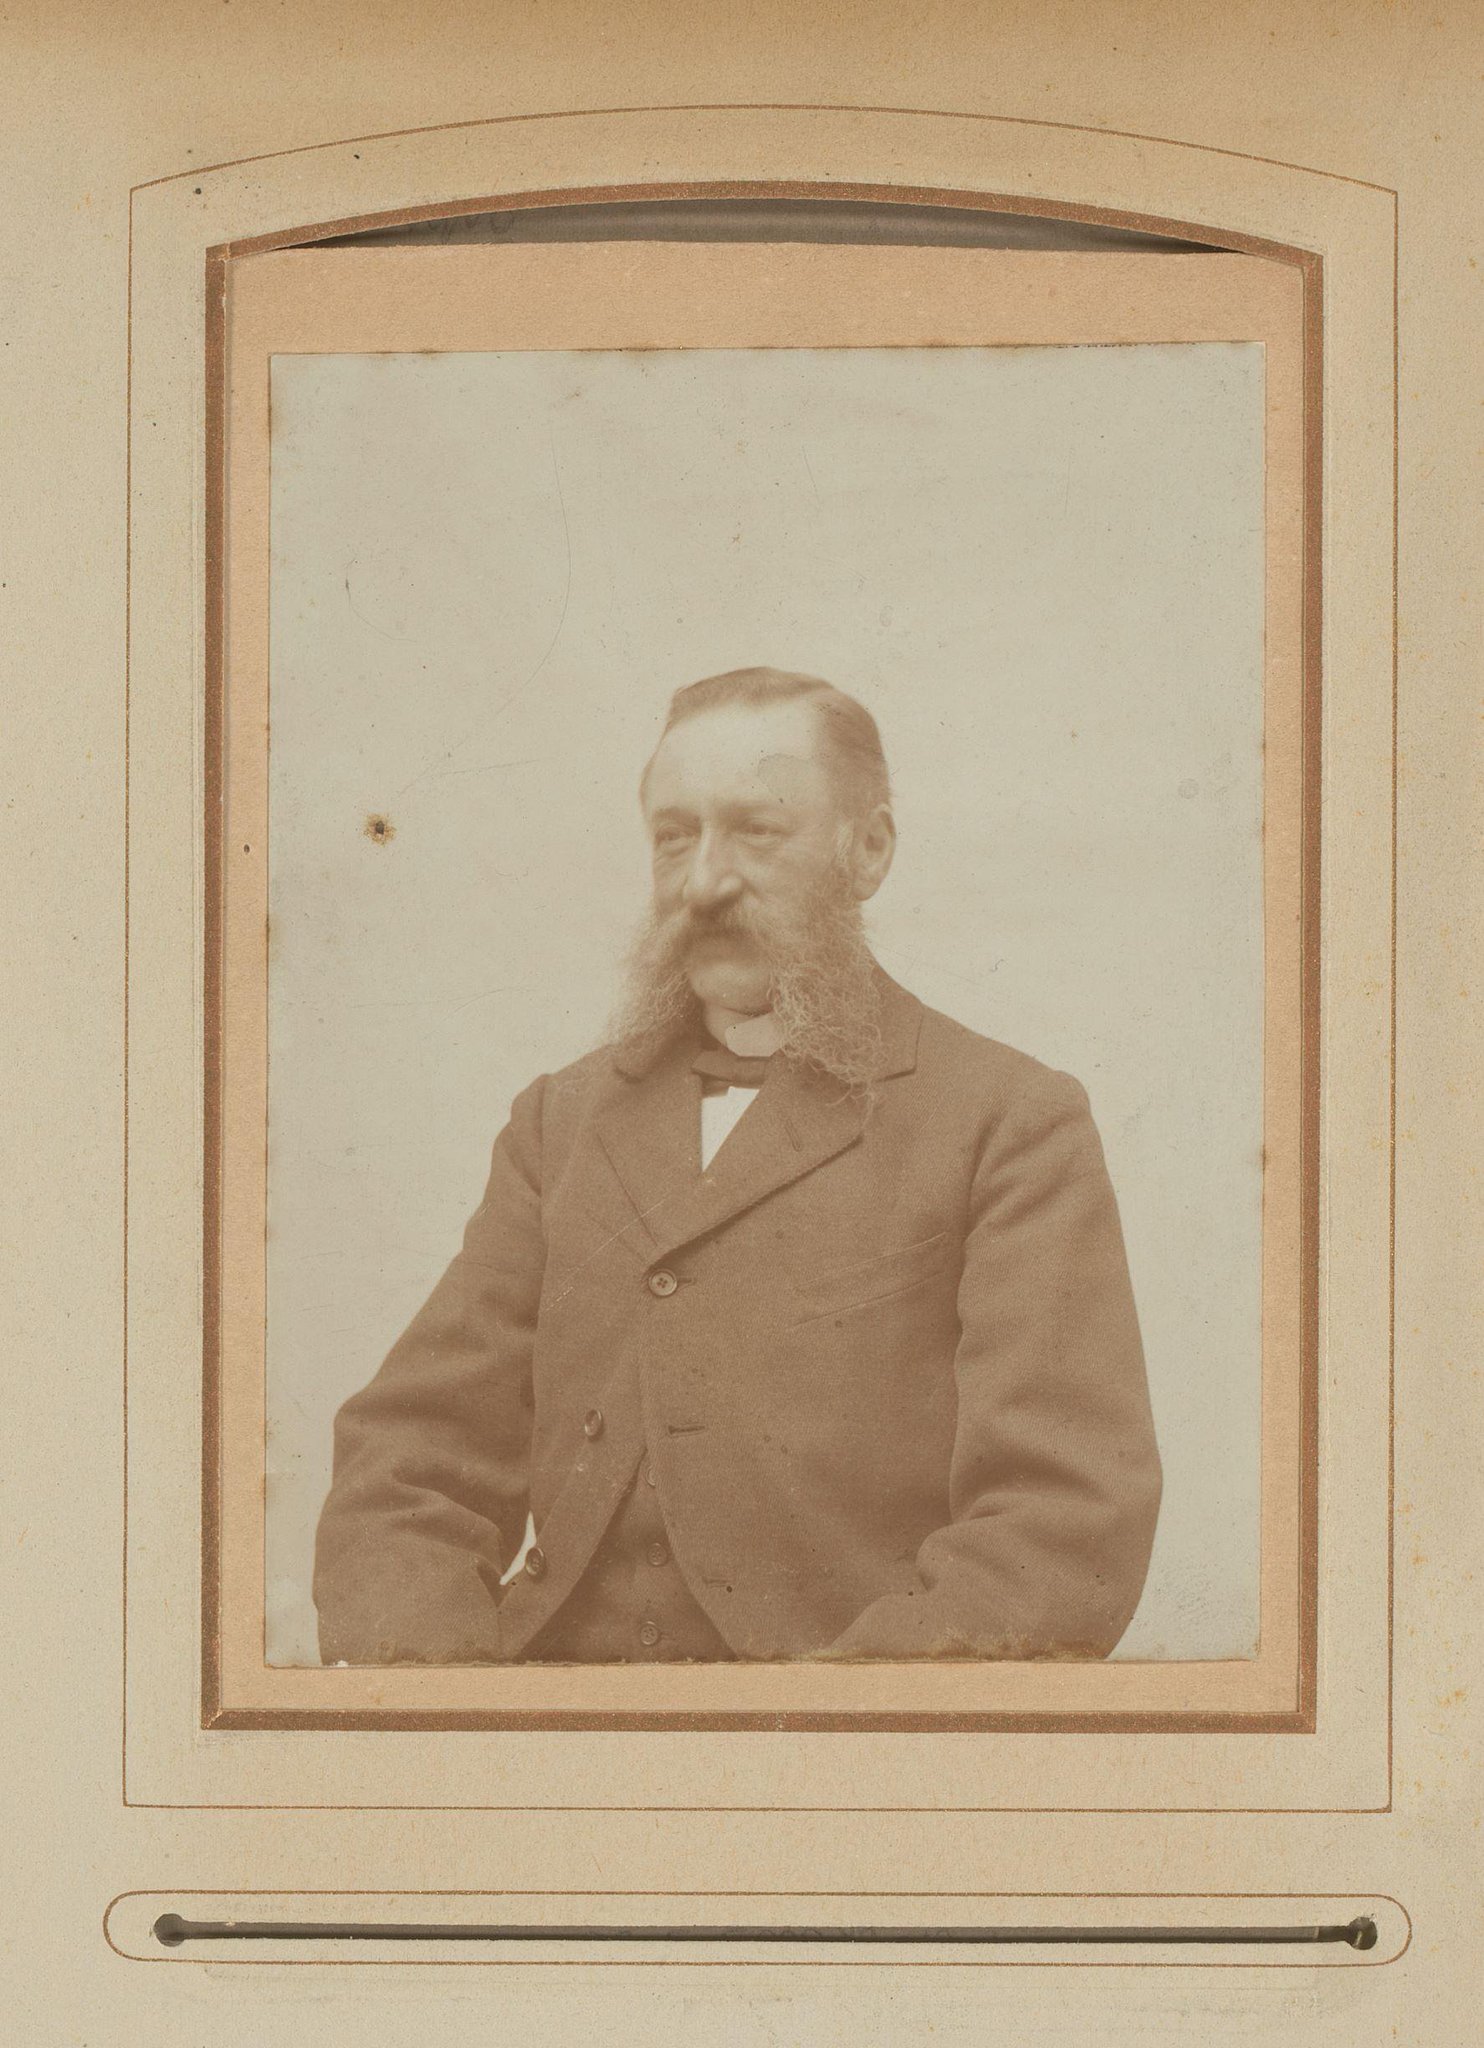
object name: cabinet photograph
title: Portret van een zittende man met snor en bakkebaarden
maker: Anonymous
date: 1880-1920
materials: cardboard, photographic support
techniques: collodion silver print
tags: sideburns, moustache, historical persons